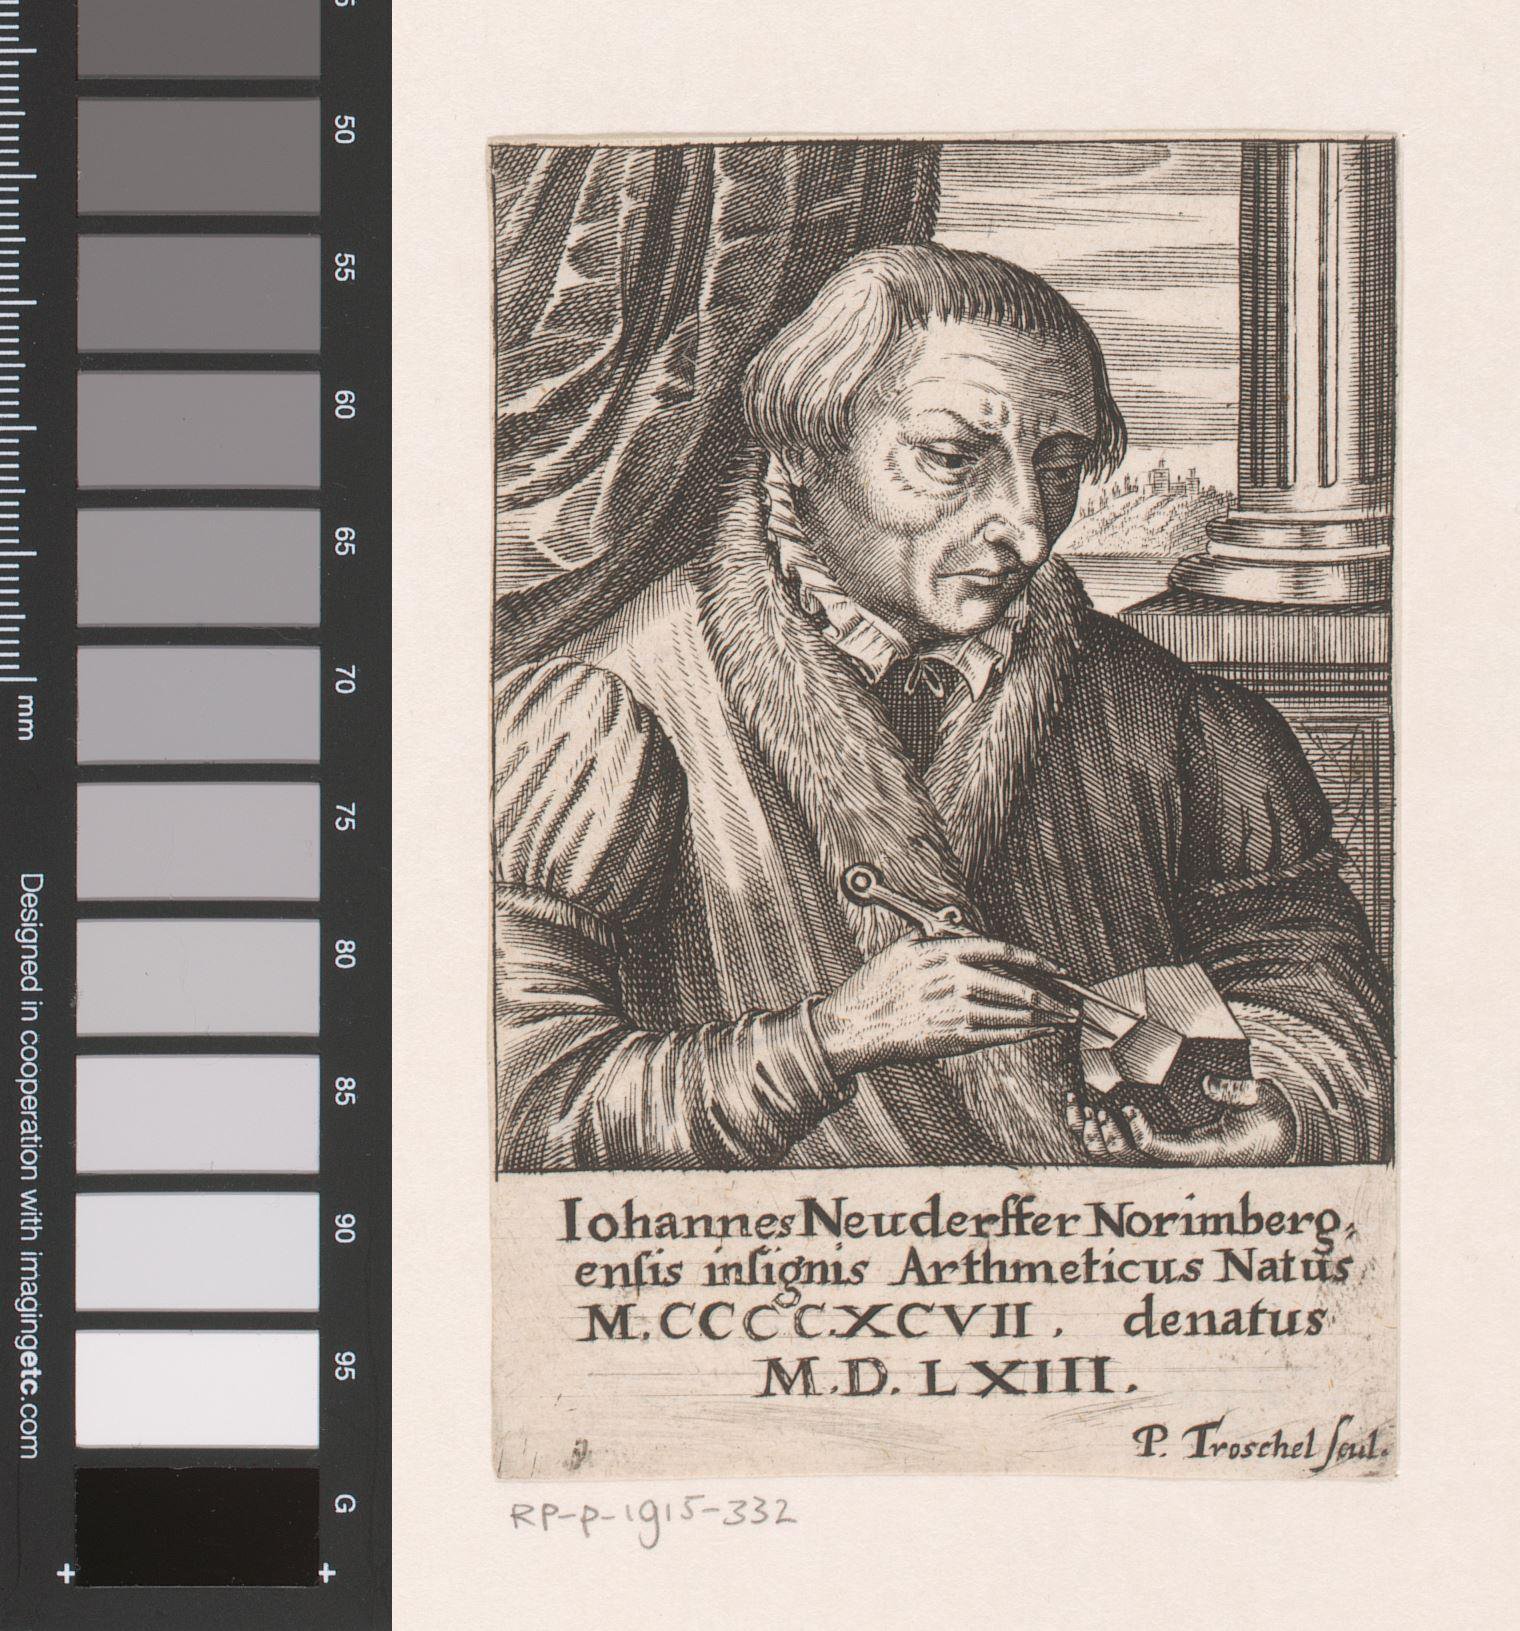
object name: print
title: Portret van Johann Neudörffer I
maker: peter troschel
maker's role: draughtsman, print maker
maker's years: 1620-1670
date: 1630-1670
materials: paper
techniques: engraving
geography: germany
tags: historical persons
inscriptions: collector's mark: Lugt 2228